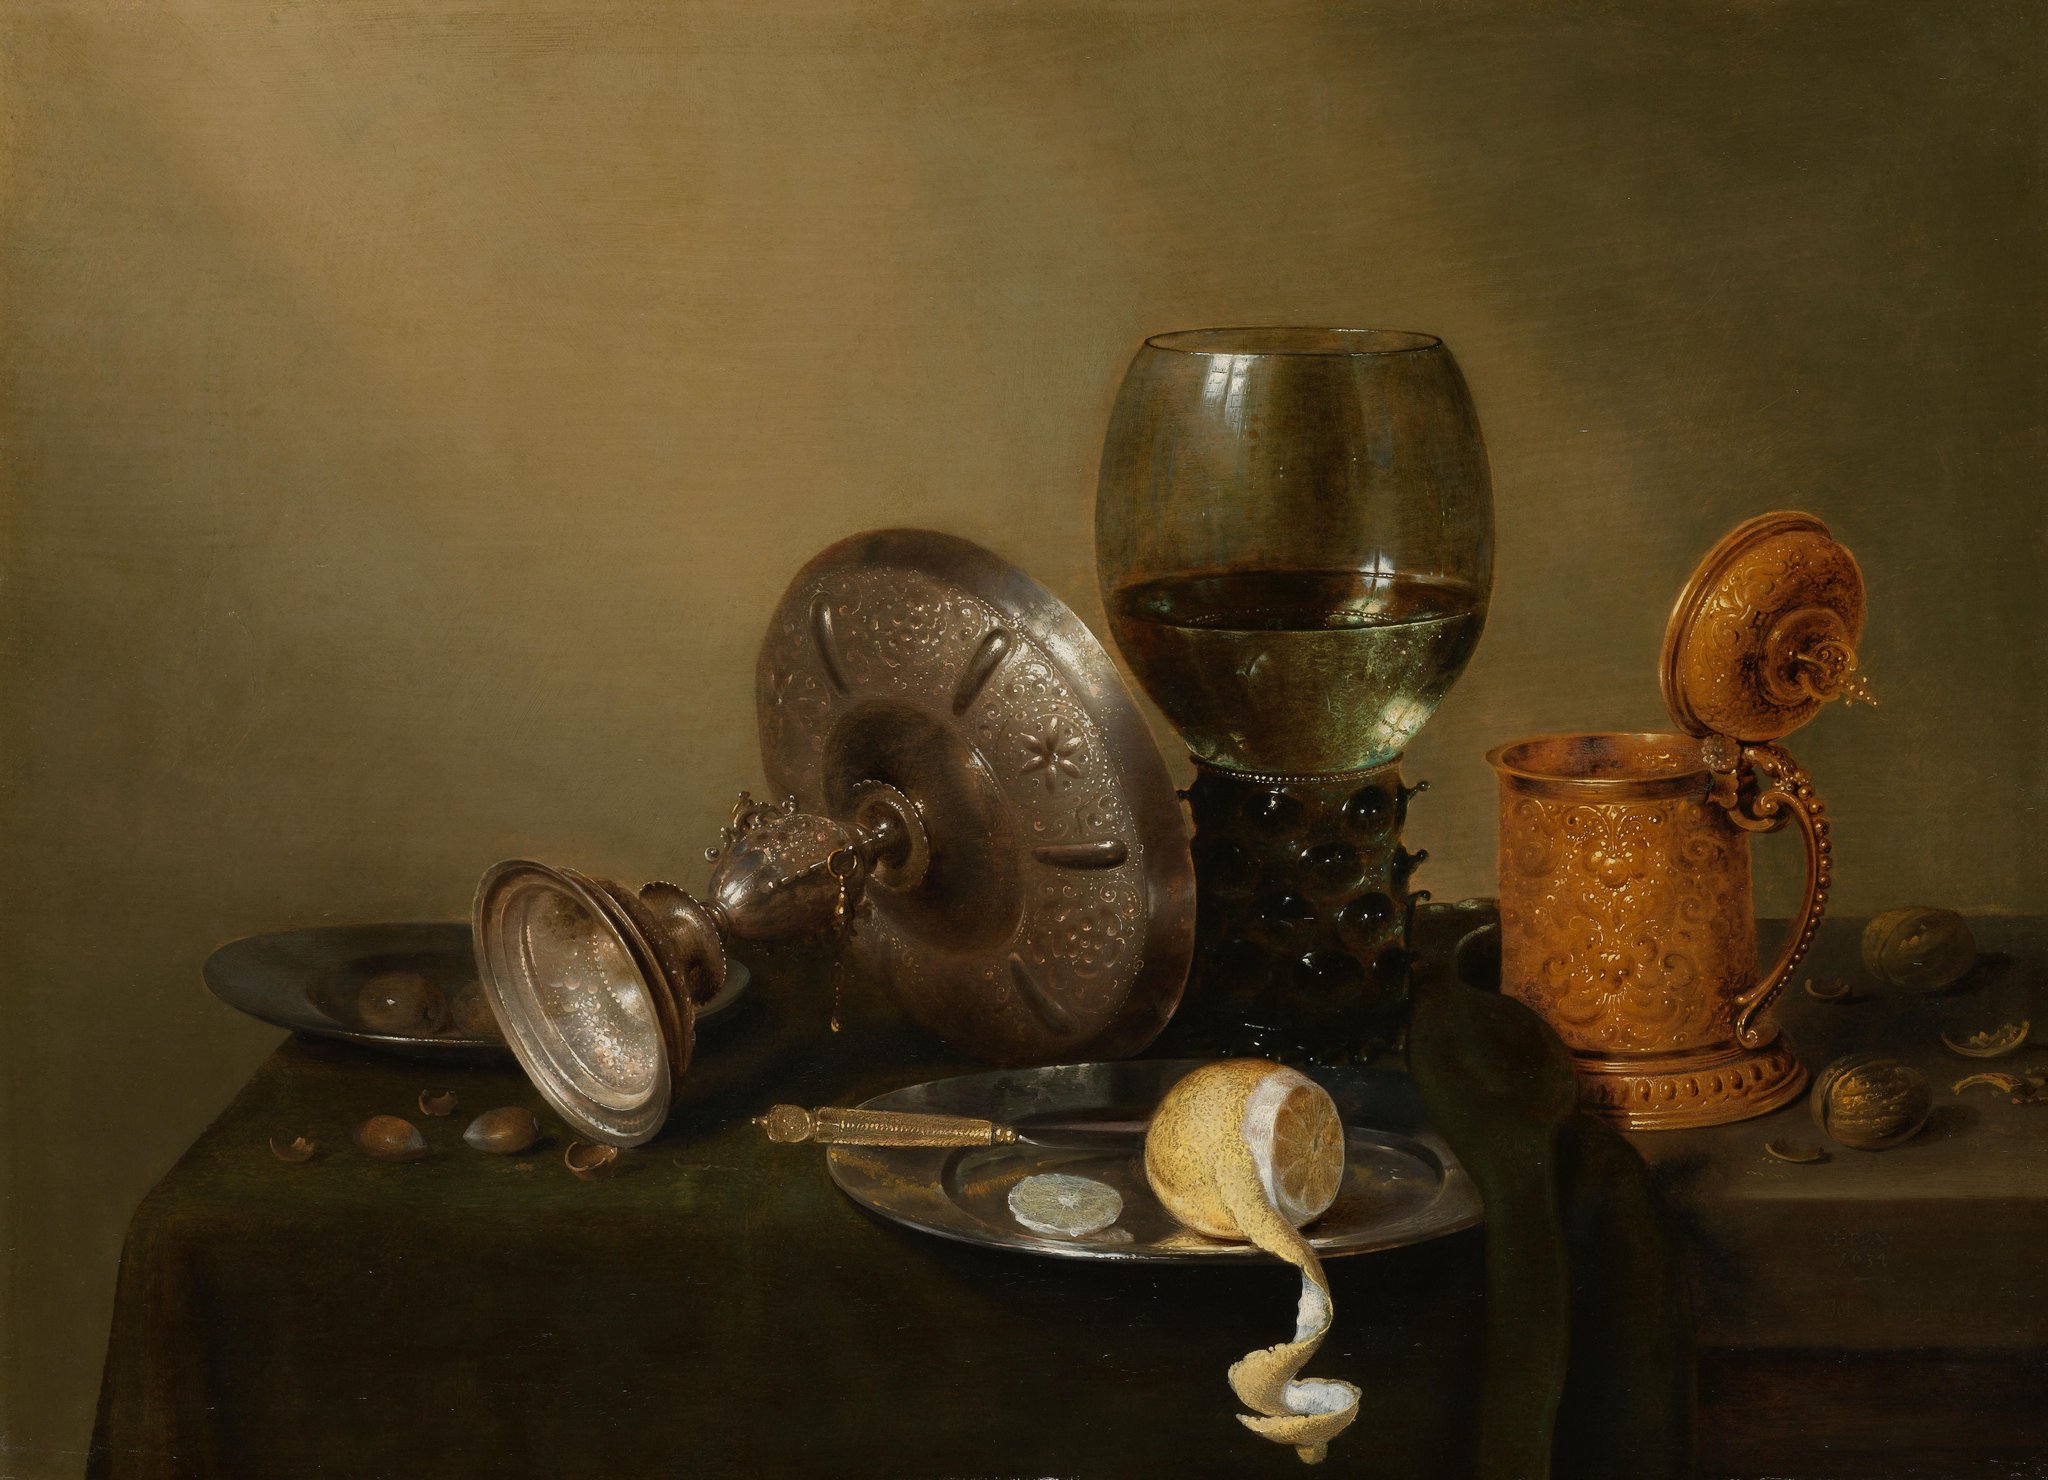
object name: painting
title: Still life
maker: willem claesz heda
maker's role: painter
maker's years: 1594-1680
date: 1634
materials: oil, panel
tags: glass of wine, laid table as still life, fruits: lemon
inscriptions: signature and date, lower right: ‘HEDA . / 1634’, signature, below that (falsely): ‘Johan d. Heem. ƒ. 1640’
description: Stilleven met een omgevallen zilveren drinkschaal, een roemer met wijn, een beker met deksel en tinnen borden met een geschilde citroen.